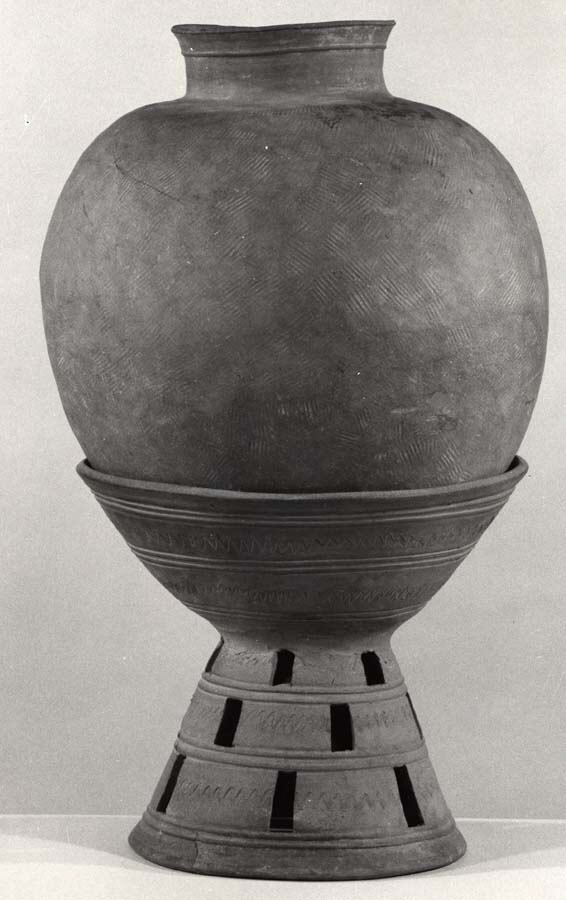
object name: vessel or stand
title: Large vessel with stand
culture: korean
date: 201-400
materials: stoneware